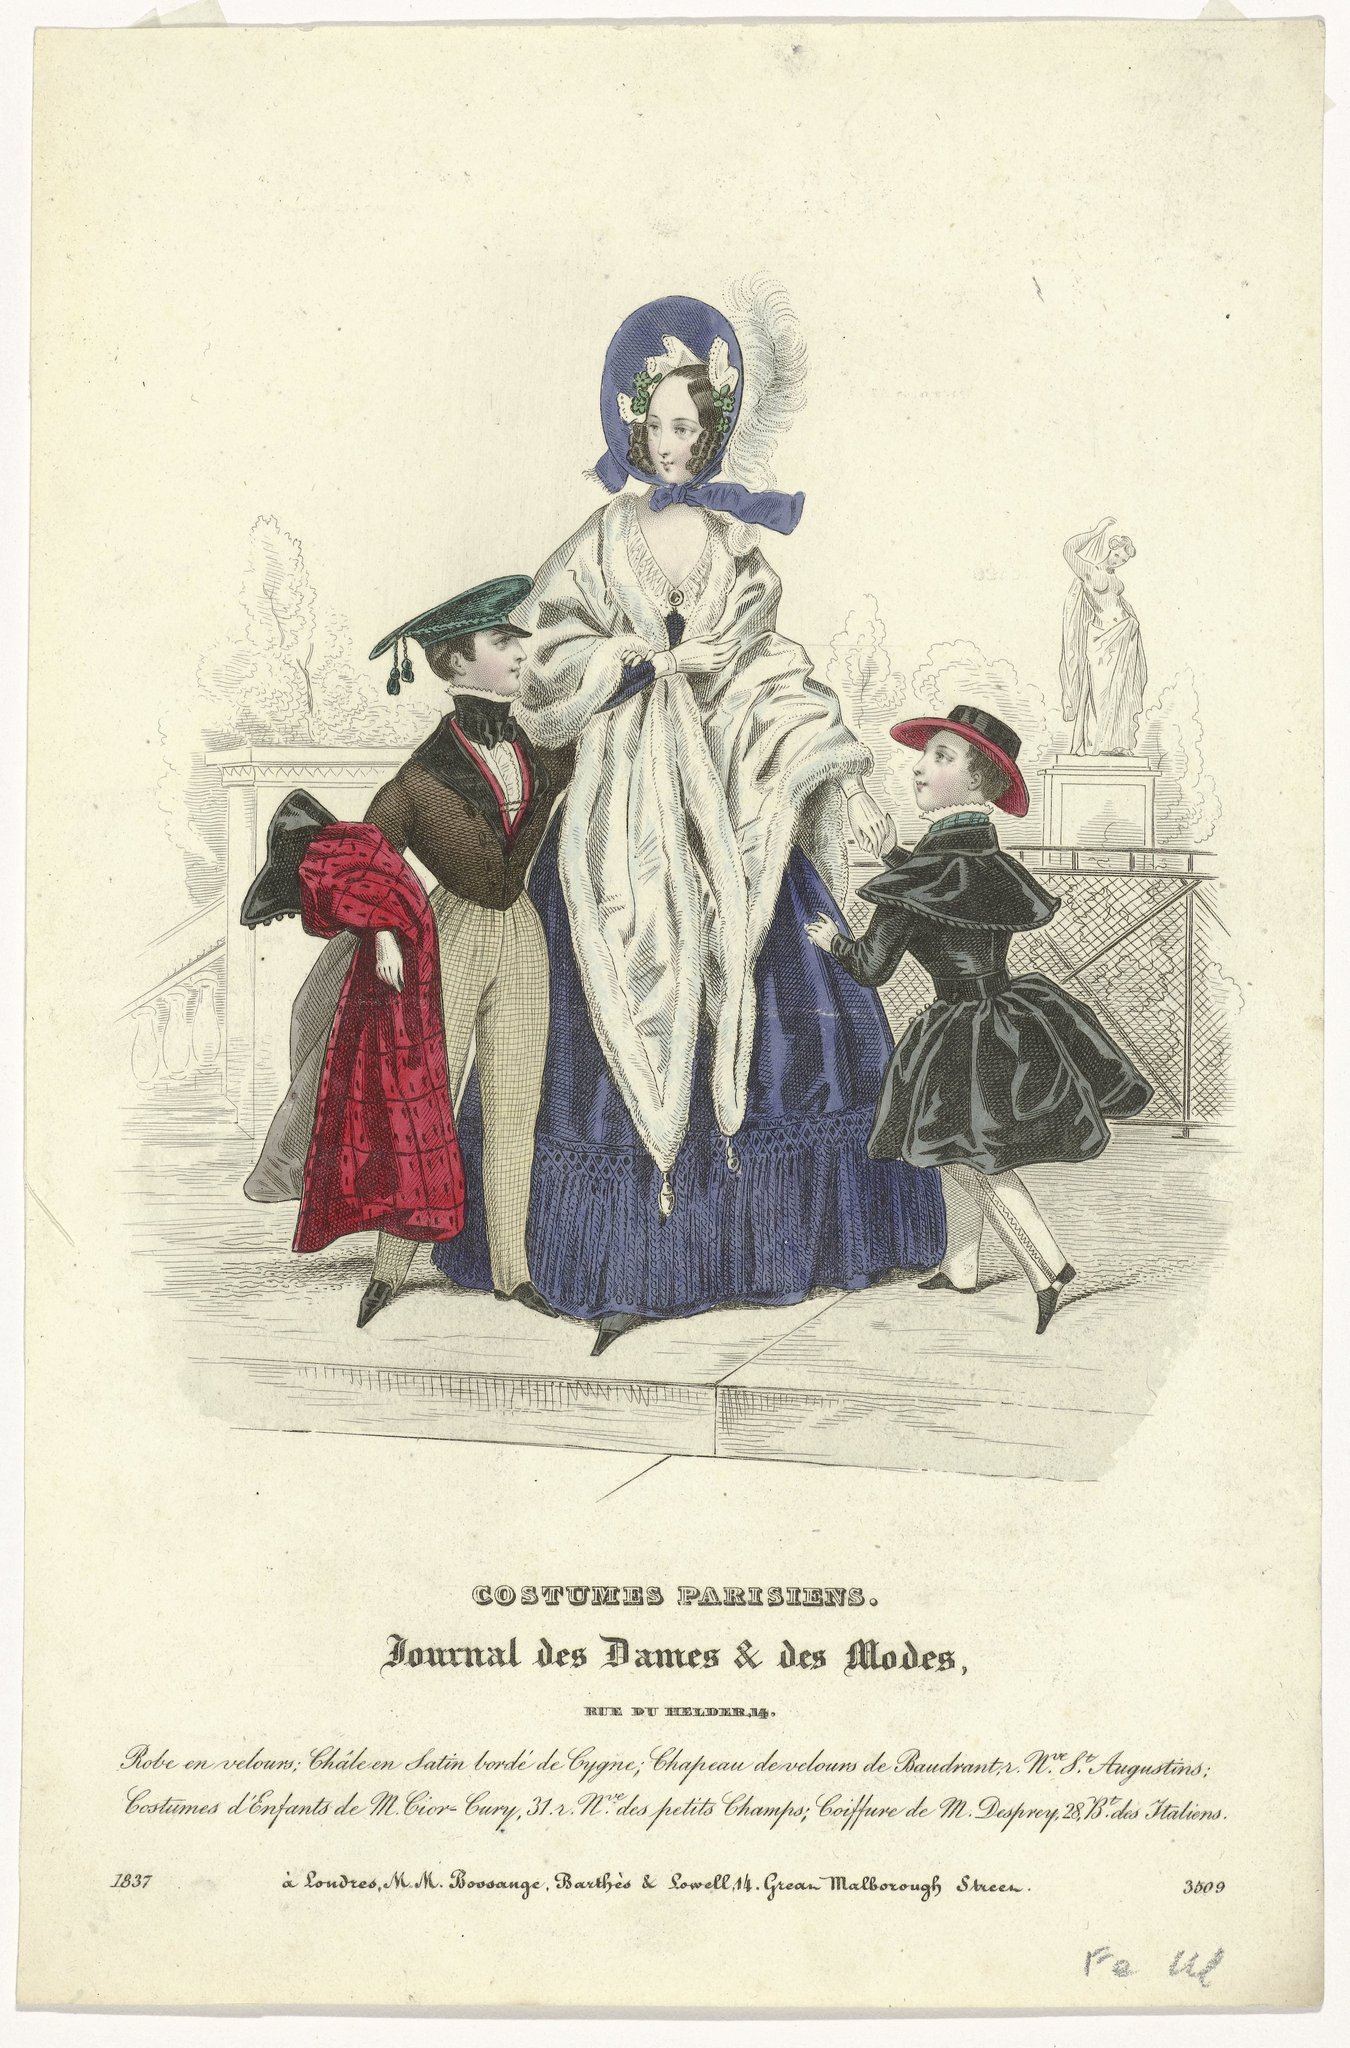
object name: fashion print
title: Journal des Dames et des Modes, Costumes Parisiens, 1837, (3509): Robe en velours (...)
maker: Anonymous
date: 1837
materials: paper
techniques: engraving, hand coloring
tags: clothes, costume (+ children's clothes), clothing for the upper part of the body (shawl) (+ women's clothes), head-gear: hat (+ girls' clothes), trousers, breeches (+ boys' clothes), shoes, sandals (+ boys' clothes), head-gear: hat (+ boys' clothes), gloves, mittens, etc. (+ boys' clothes), fashion plates, clothes, costume (+ women's clothes), head-gear: hat (+ women's clothes), gloves, mittens, etc. (+ women's clothes), dress, gown (+ women's clothes), dress, gown (+ girls' clothes)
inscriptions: title: ‘Costumes Parisiens. / Journal des Dames & des Modes,’, address: ‘Rue du Helder,14. / à Londres, M.M. Bossange, Barthès & Lowell, 14. Grean Malborough Street.’, caption: ‘Robe en velours; Châle en Satin bordé de Cygne; Chapeau de velours de Baudrant, r. N.ve St. Augustins: Costumes d'Enfants de M. Cior-Cury, 31.r.N.ve des petits Champs; Coiffure de M. Desprey, 28, Bt. des Italiens.’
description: Een vrouw en twee jongens in een park. De vrouw draagt een japon van fluweel. Om de schouders een sjaal van satijn, afgezet met zwanendons. Hoed van fluweel van Baudrant. De jongens dragen kinderkleding van M. Cior-Cury. 'Coiffure' van M. Desprey. De prent maakt deel uit van het modetijdschrift Journal des Dames et des Modes, Parijs, 1797-1839.